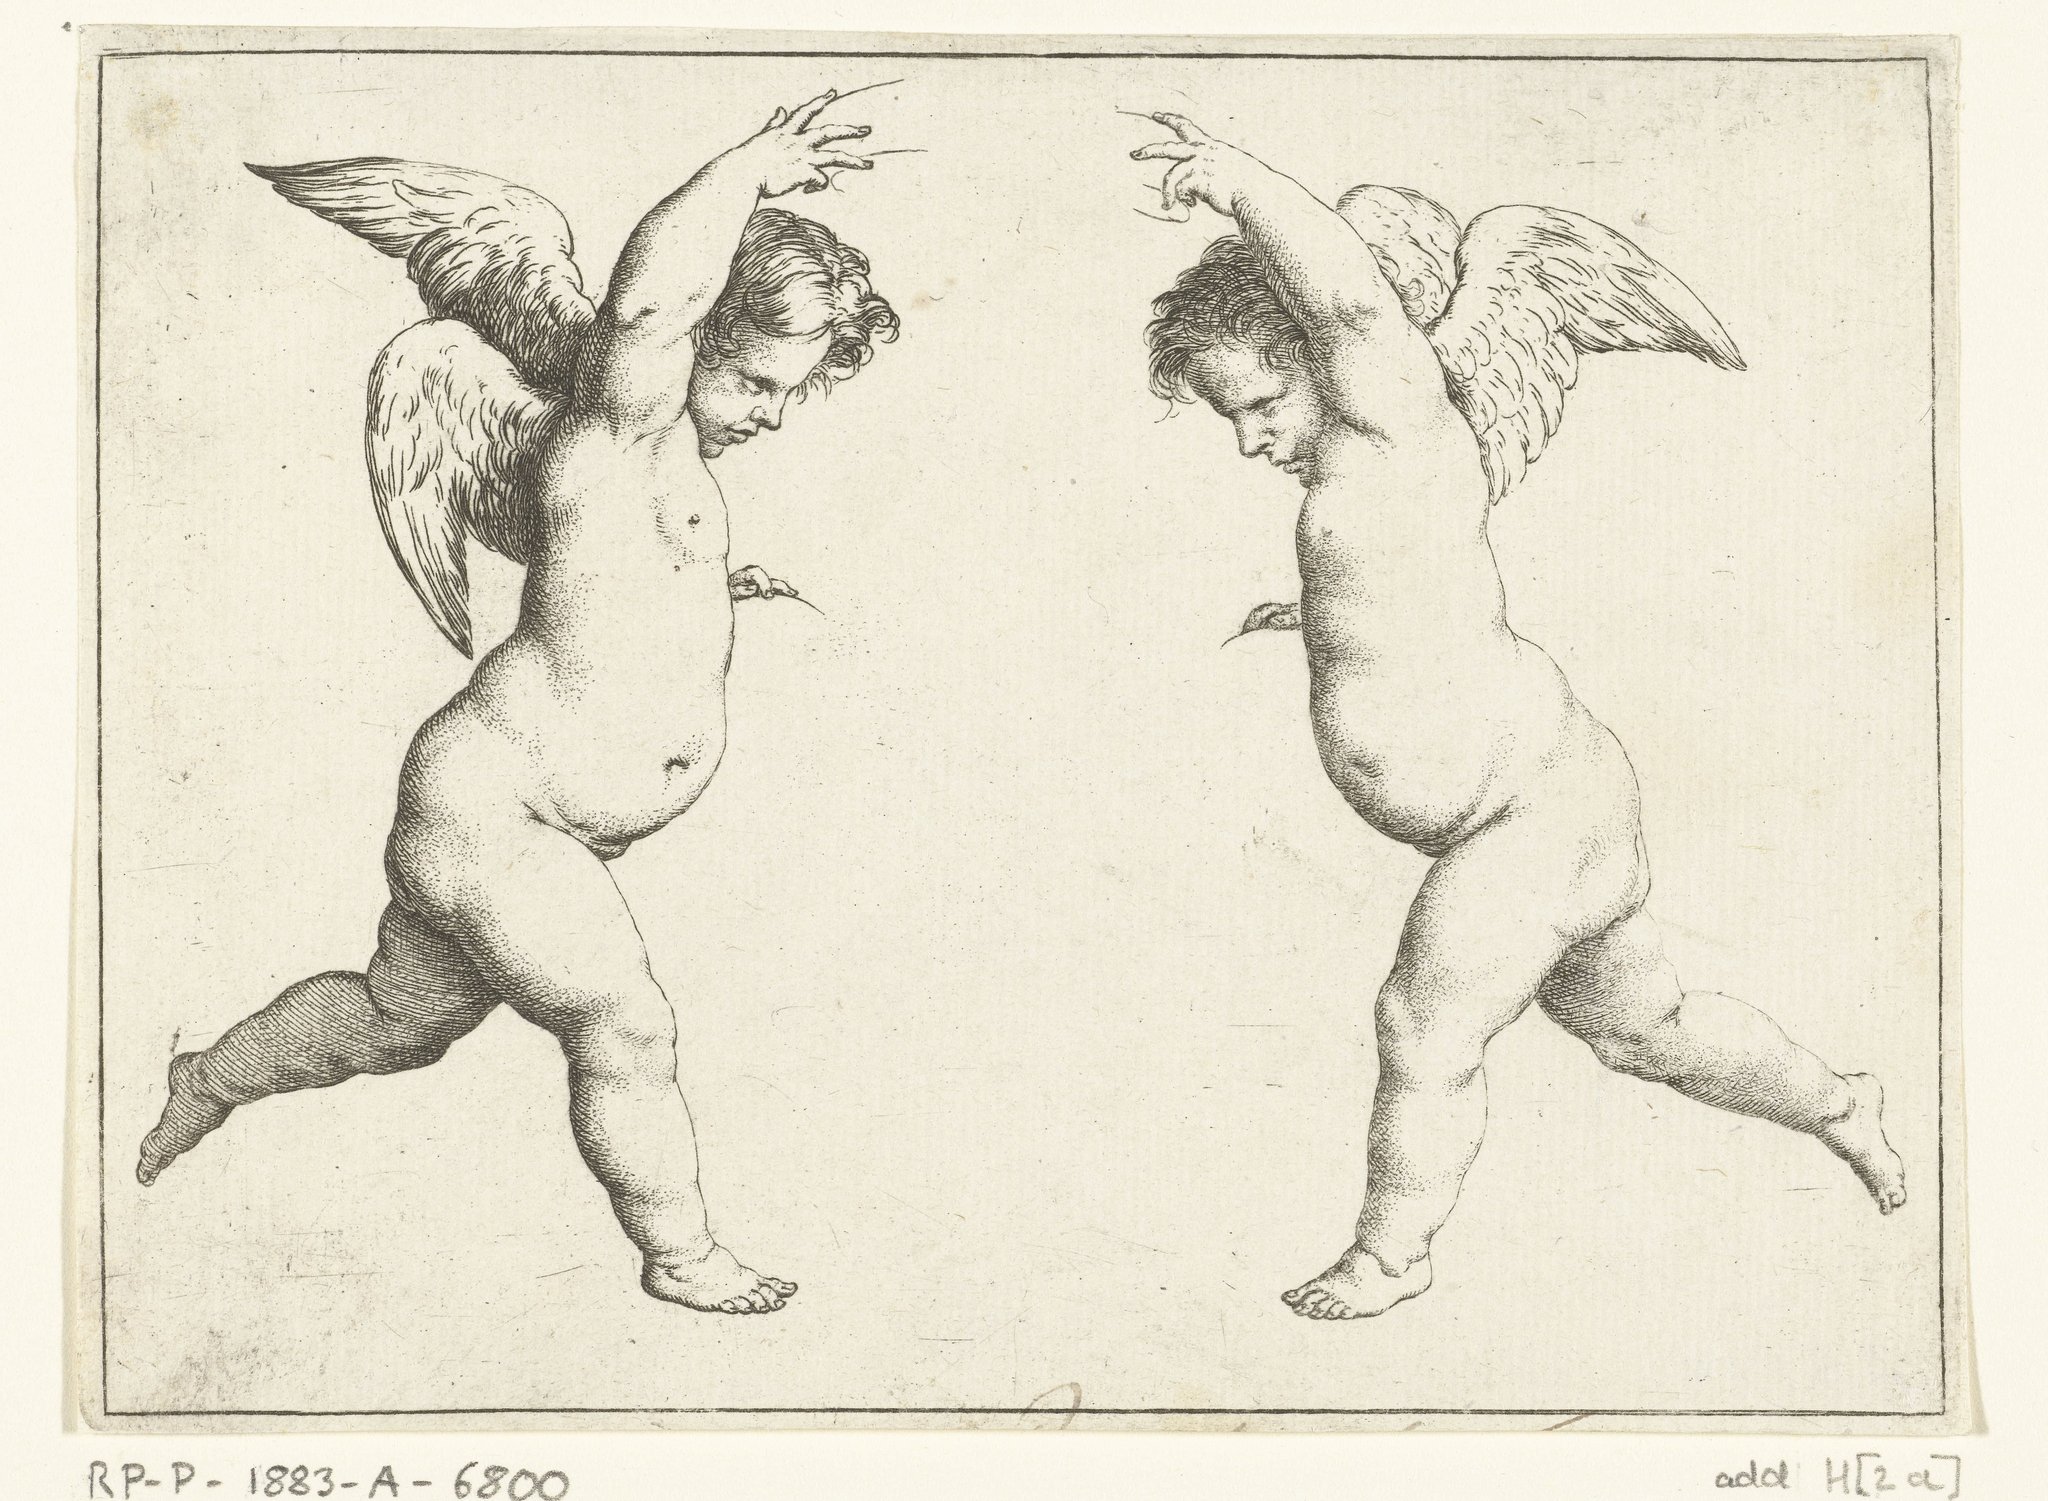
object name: print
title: Twee engelen tegenover elkaar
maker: pieter van avont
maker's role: print maker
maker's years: 1600-1652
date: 1622-1652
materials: paper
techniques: engraving, etching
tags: angels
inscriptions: collector's mark: Lugt 2228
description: Twee kleine engelen staan tegenover elkaar. Ze houden een lint boven hun hoofd.